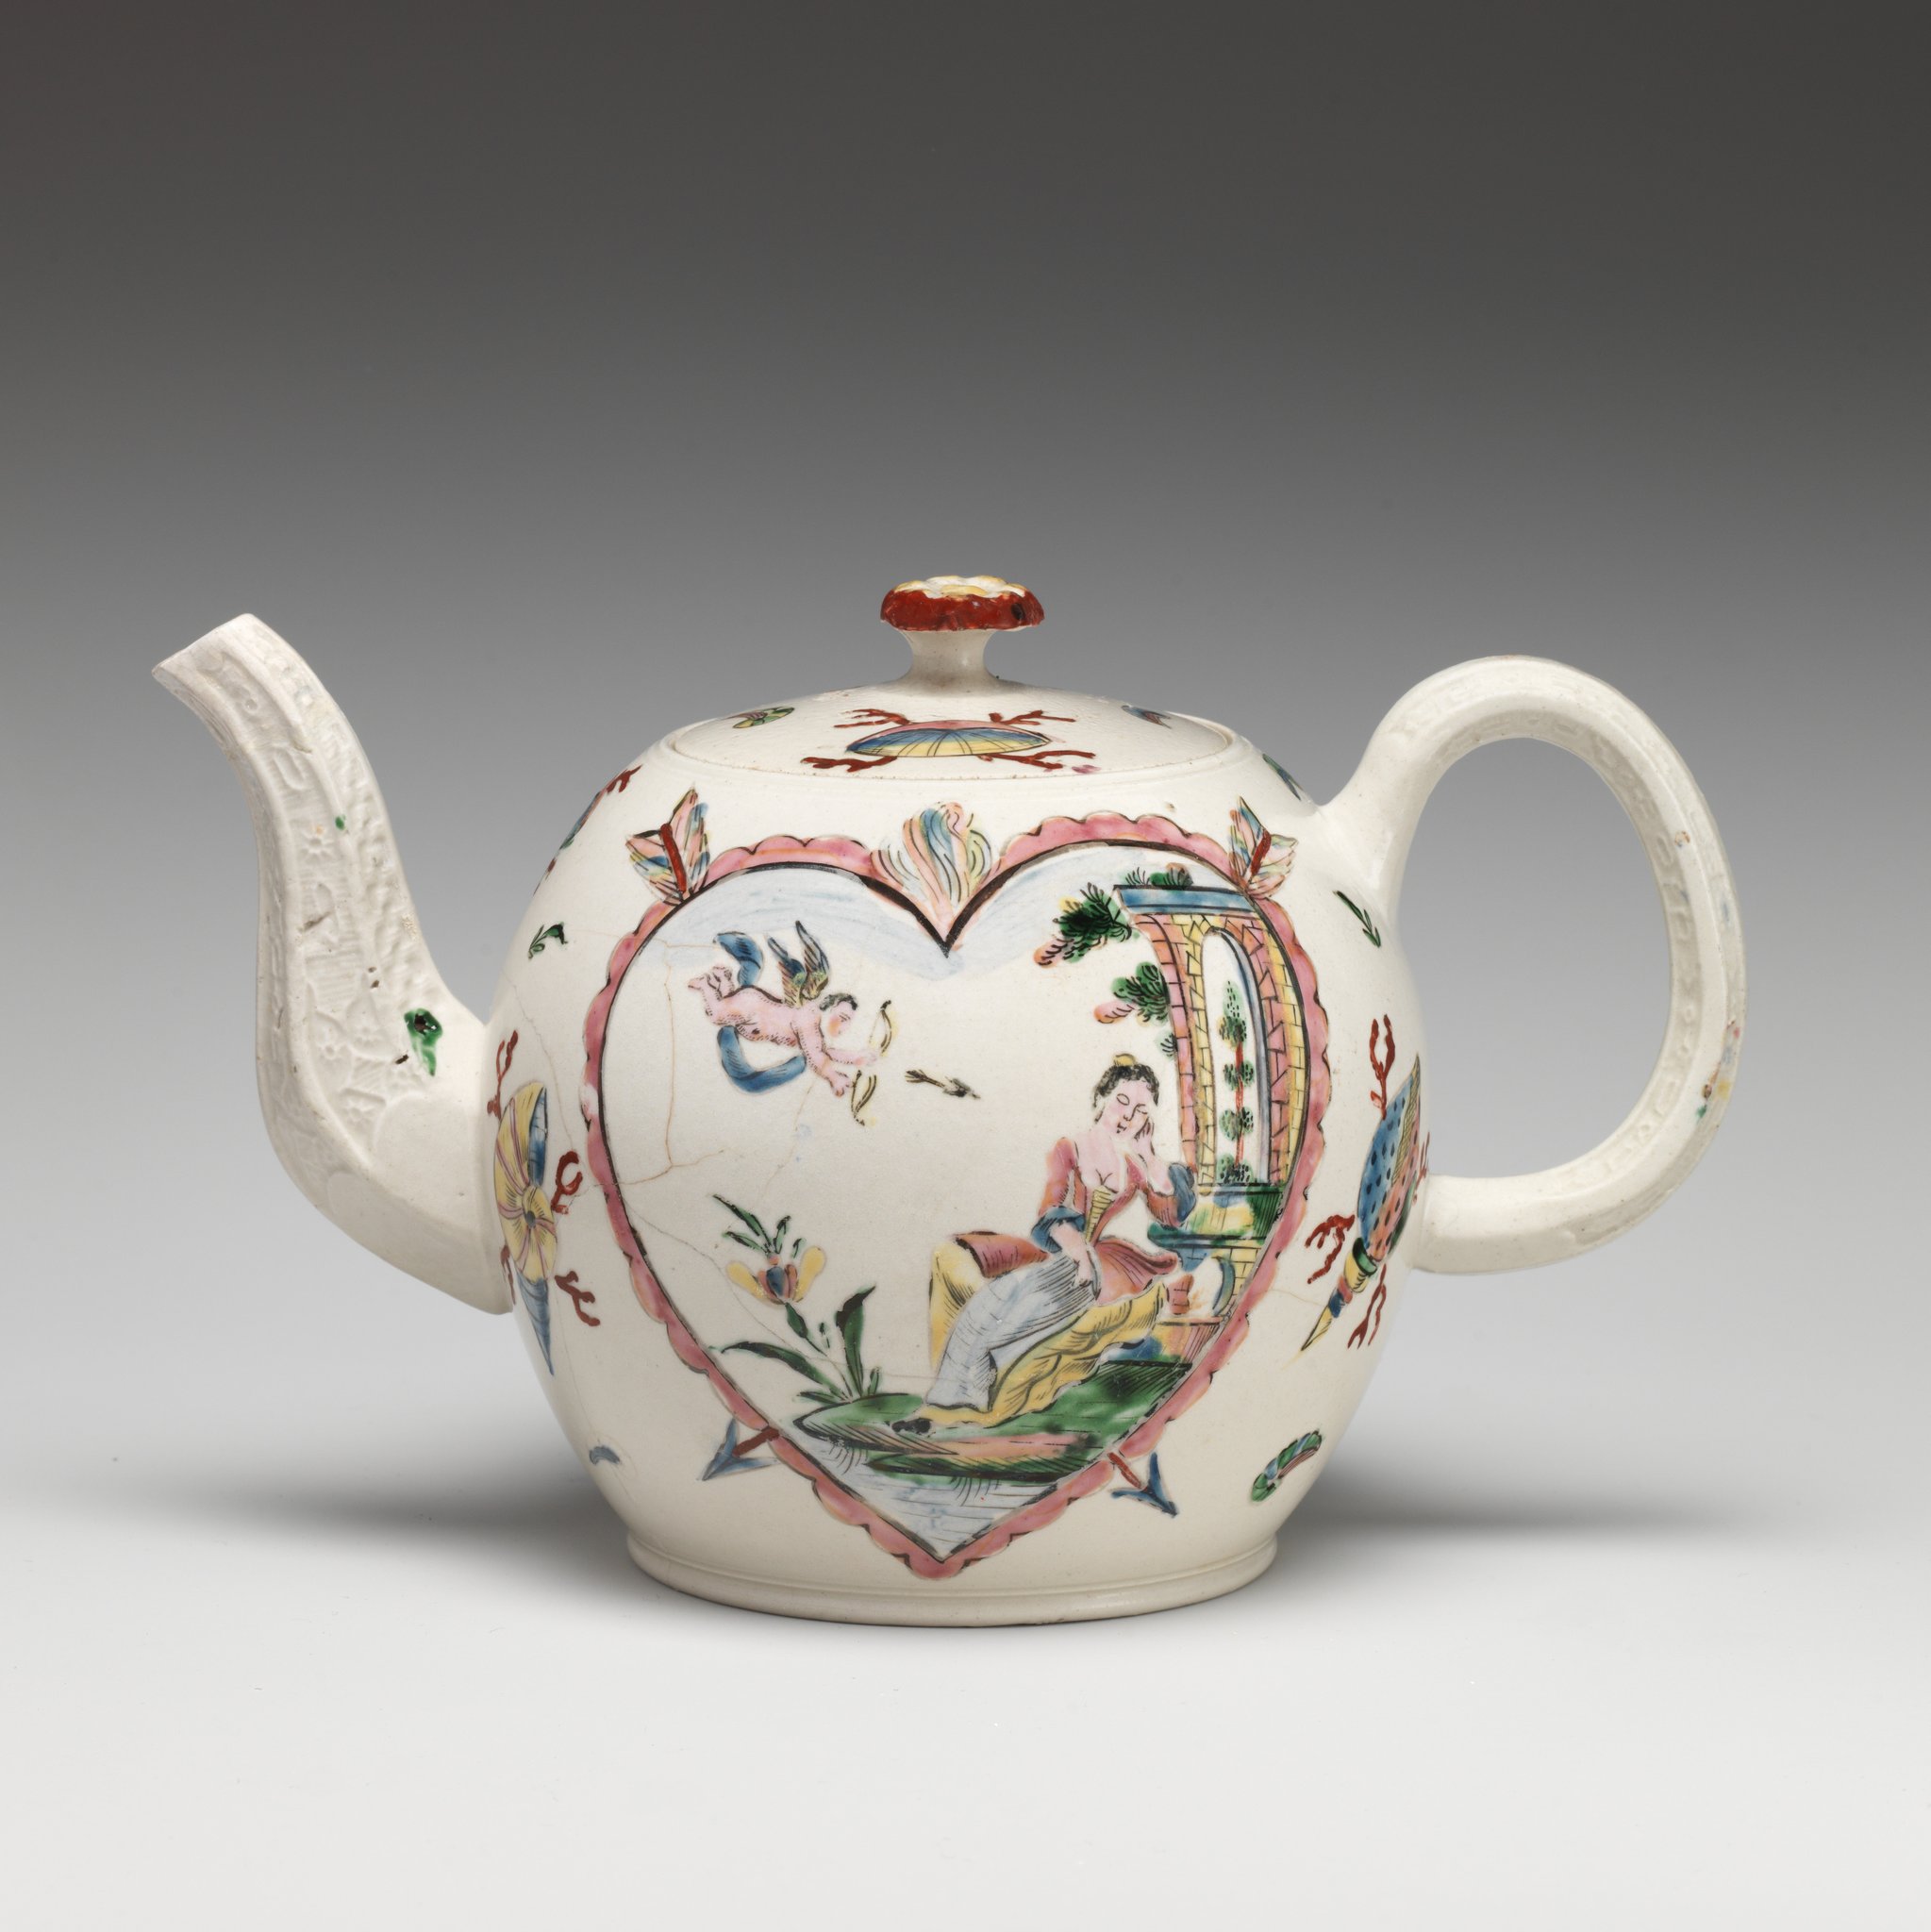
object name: teapot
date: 1760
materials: enamel, stoneware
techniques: salt glaze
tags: women,cupid